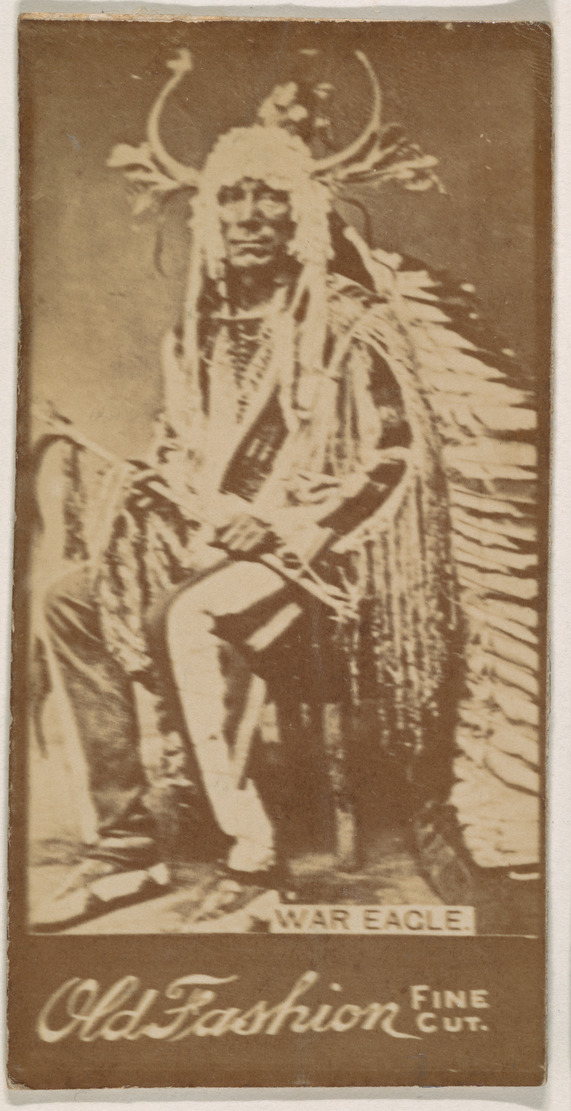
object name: photograph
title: War Eagle, from the Indian Chiefs series (N681) promoting Old Fashion Fine Cut Tobacco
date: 1888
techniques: albumen silver print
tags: men,portraits